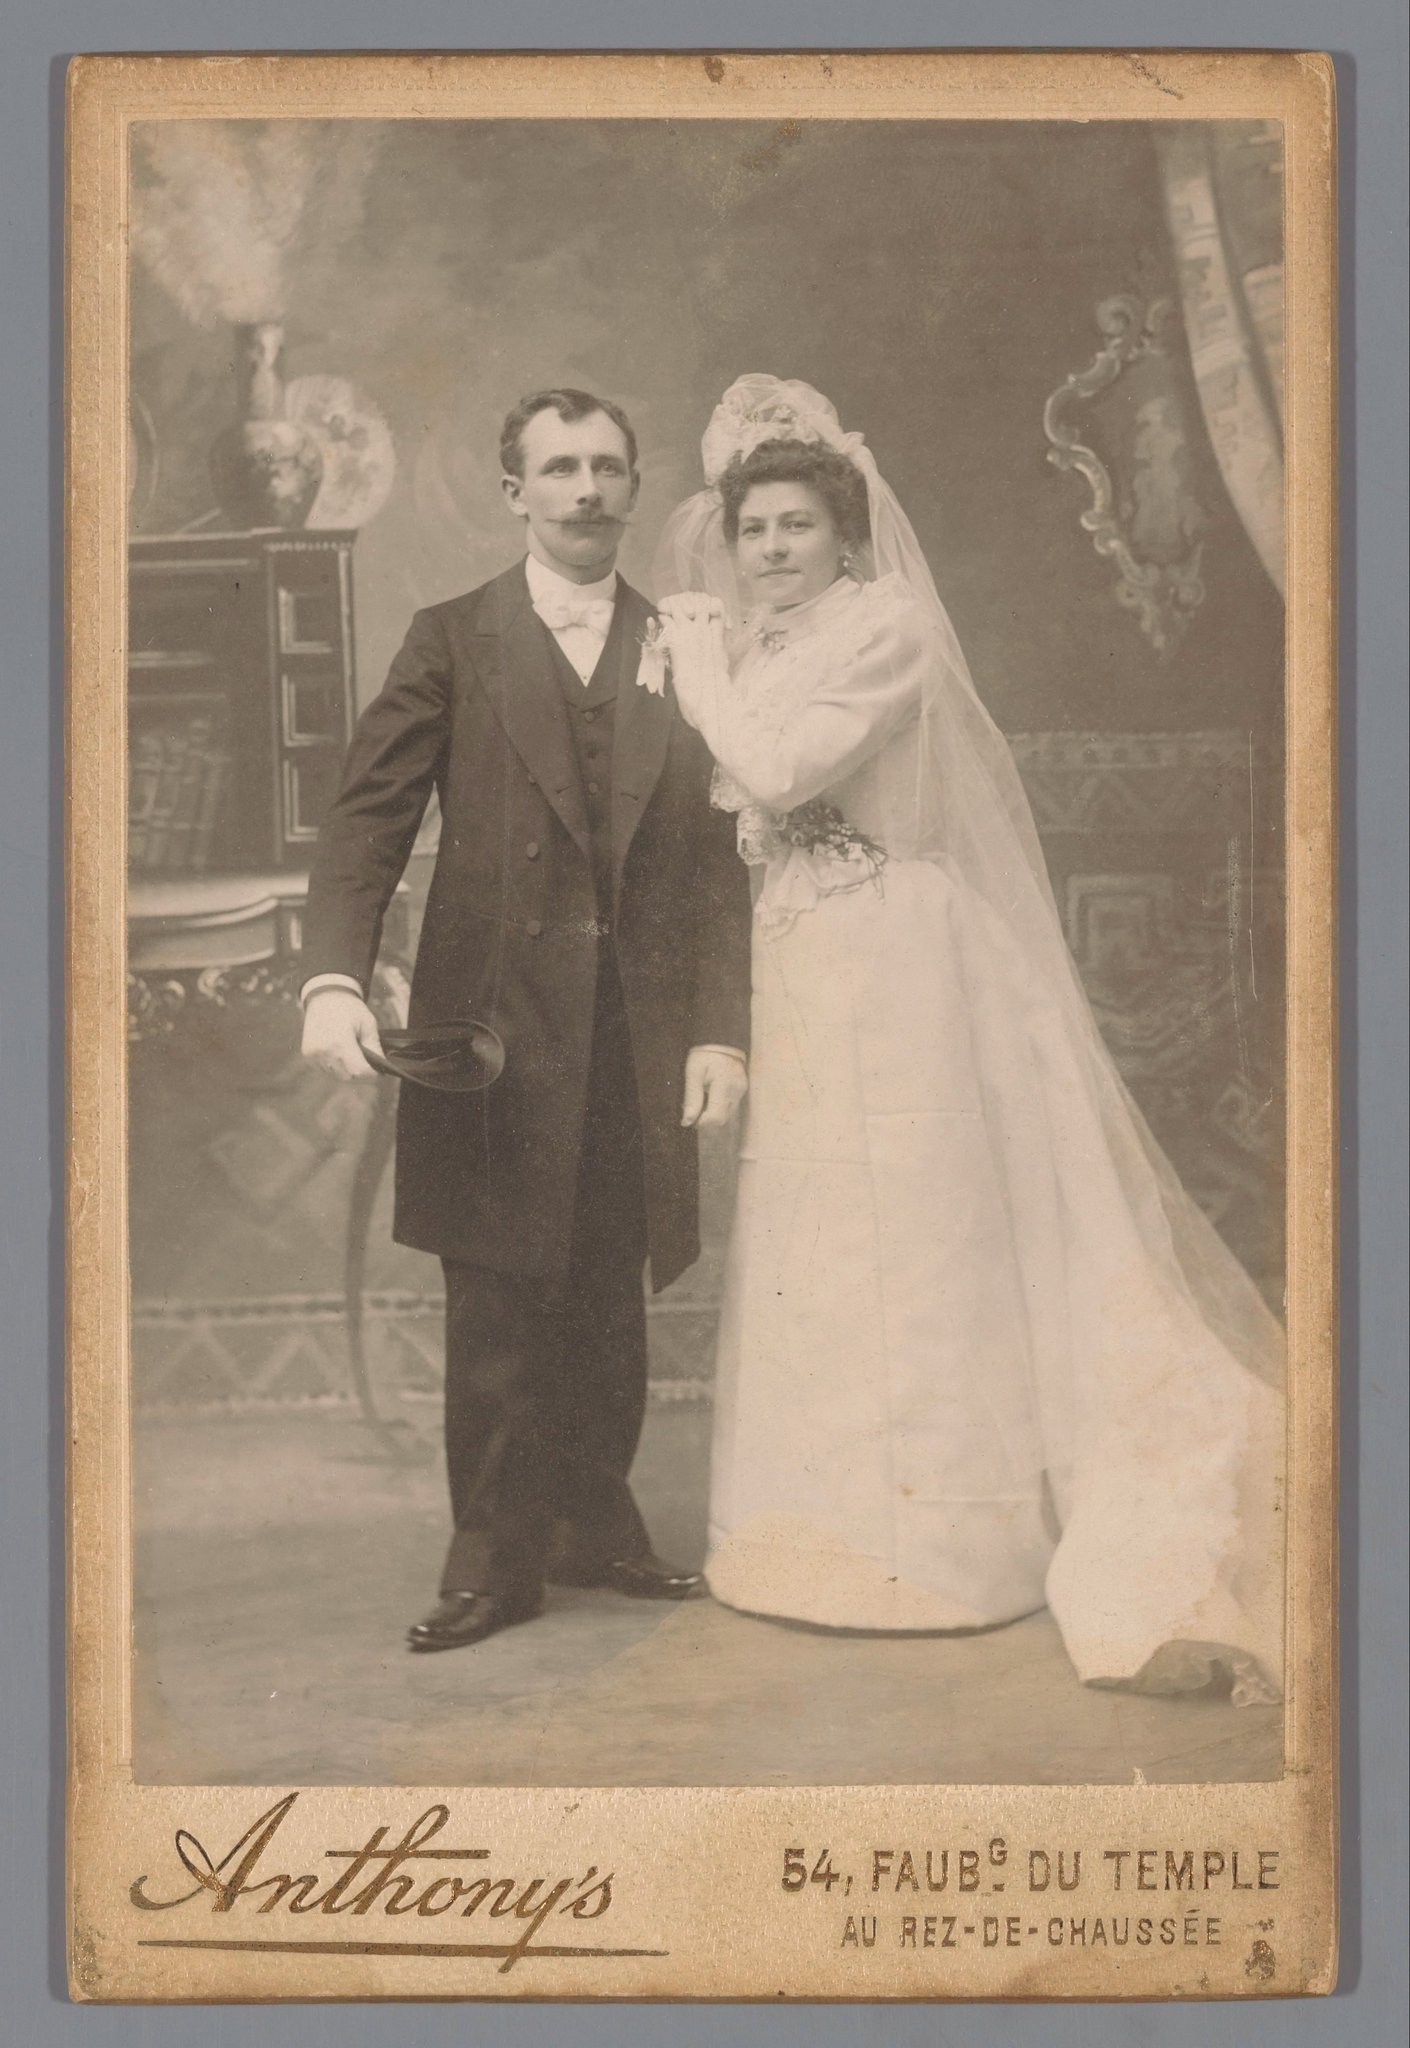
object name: cabinet photograph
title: Portret van een onbekend bruidspaar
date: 1870-1910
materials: cardboard, photographic support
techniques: collodion silver print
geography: paris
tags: studio requisites ~ photographer, bride and groom in wedding-dress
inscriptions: name: ‘Anthony's Paris 54, Faubourg du Temple, 54 (...)’